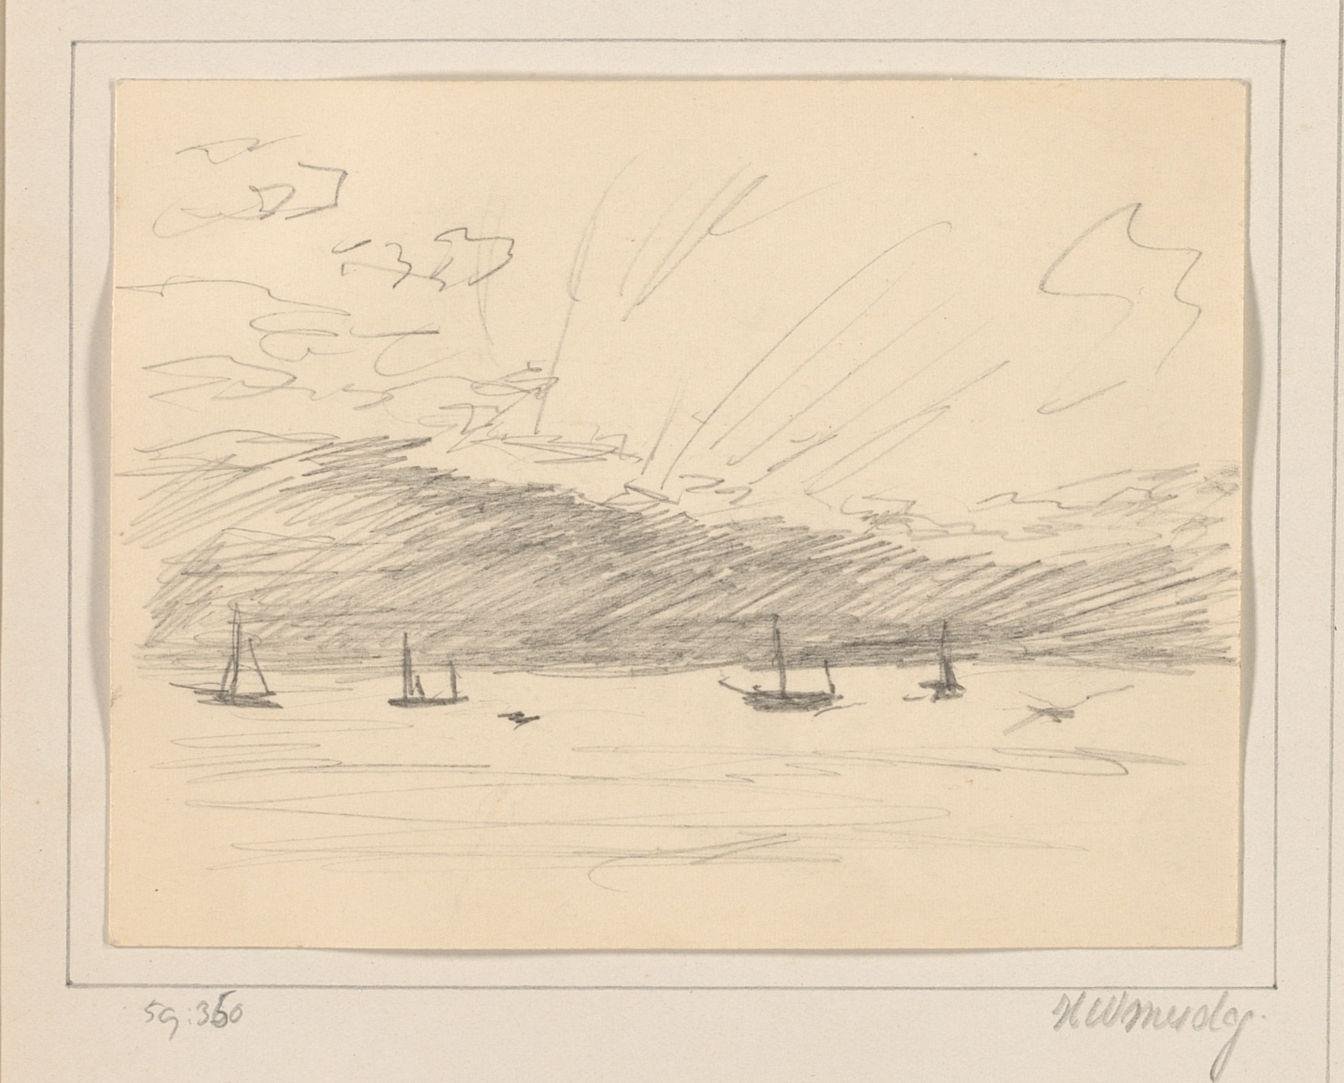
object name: drawing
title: Zeegezicht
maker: hendrik willem mesdag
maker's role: draughtsman, painter, print maker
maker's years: 1831-1915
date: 1831-1915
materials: paper, pencil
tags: ships (in general), sea (seascape)